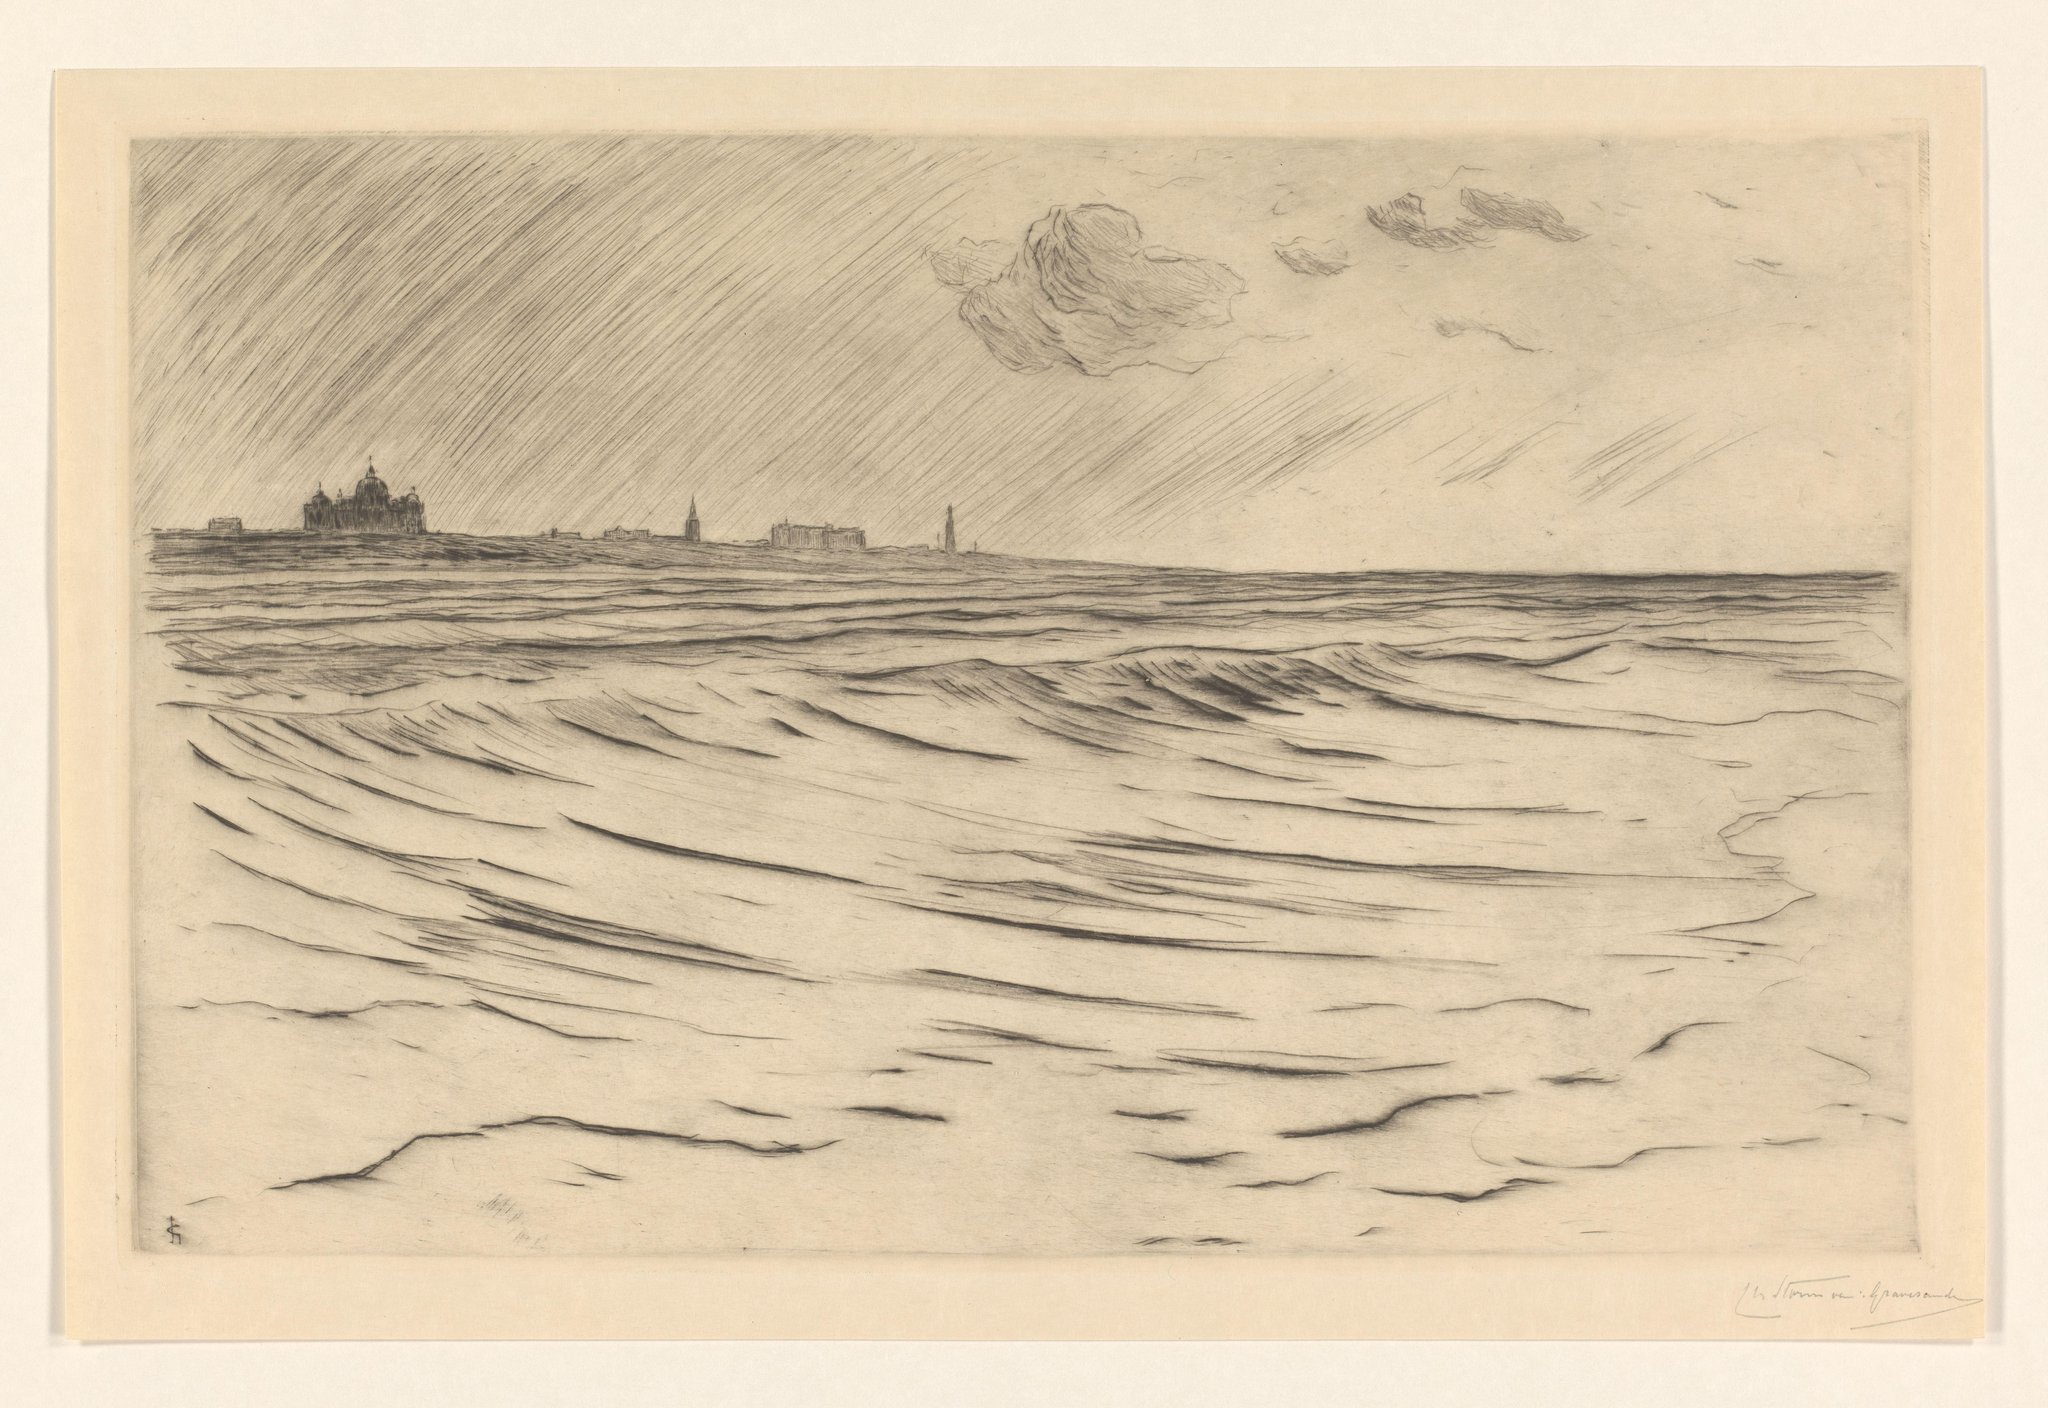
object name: print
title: Gezicht op de kust bij Scheveningen gezien vanaf de pier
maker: carel nicolaas storm van s-gravesande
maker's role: draughtsman, print maker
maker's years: 1841-1924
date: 1851-1902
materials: paper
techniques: drypoint, intaglio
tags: coast, sea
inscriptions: collector's mark: Lugt 2228